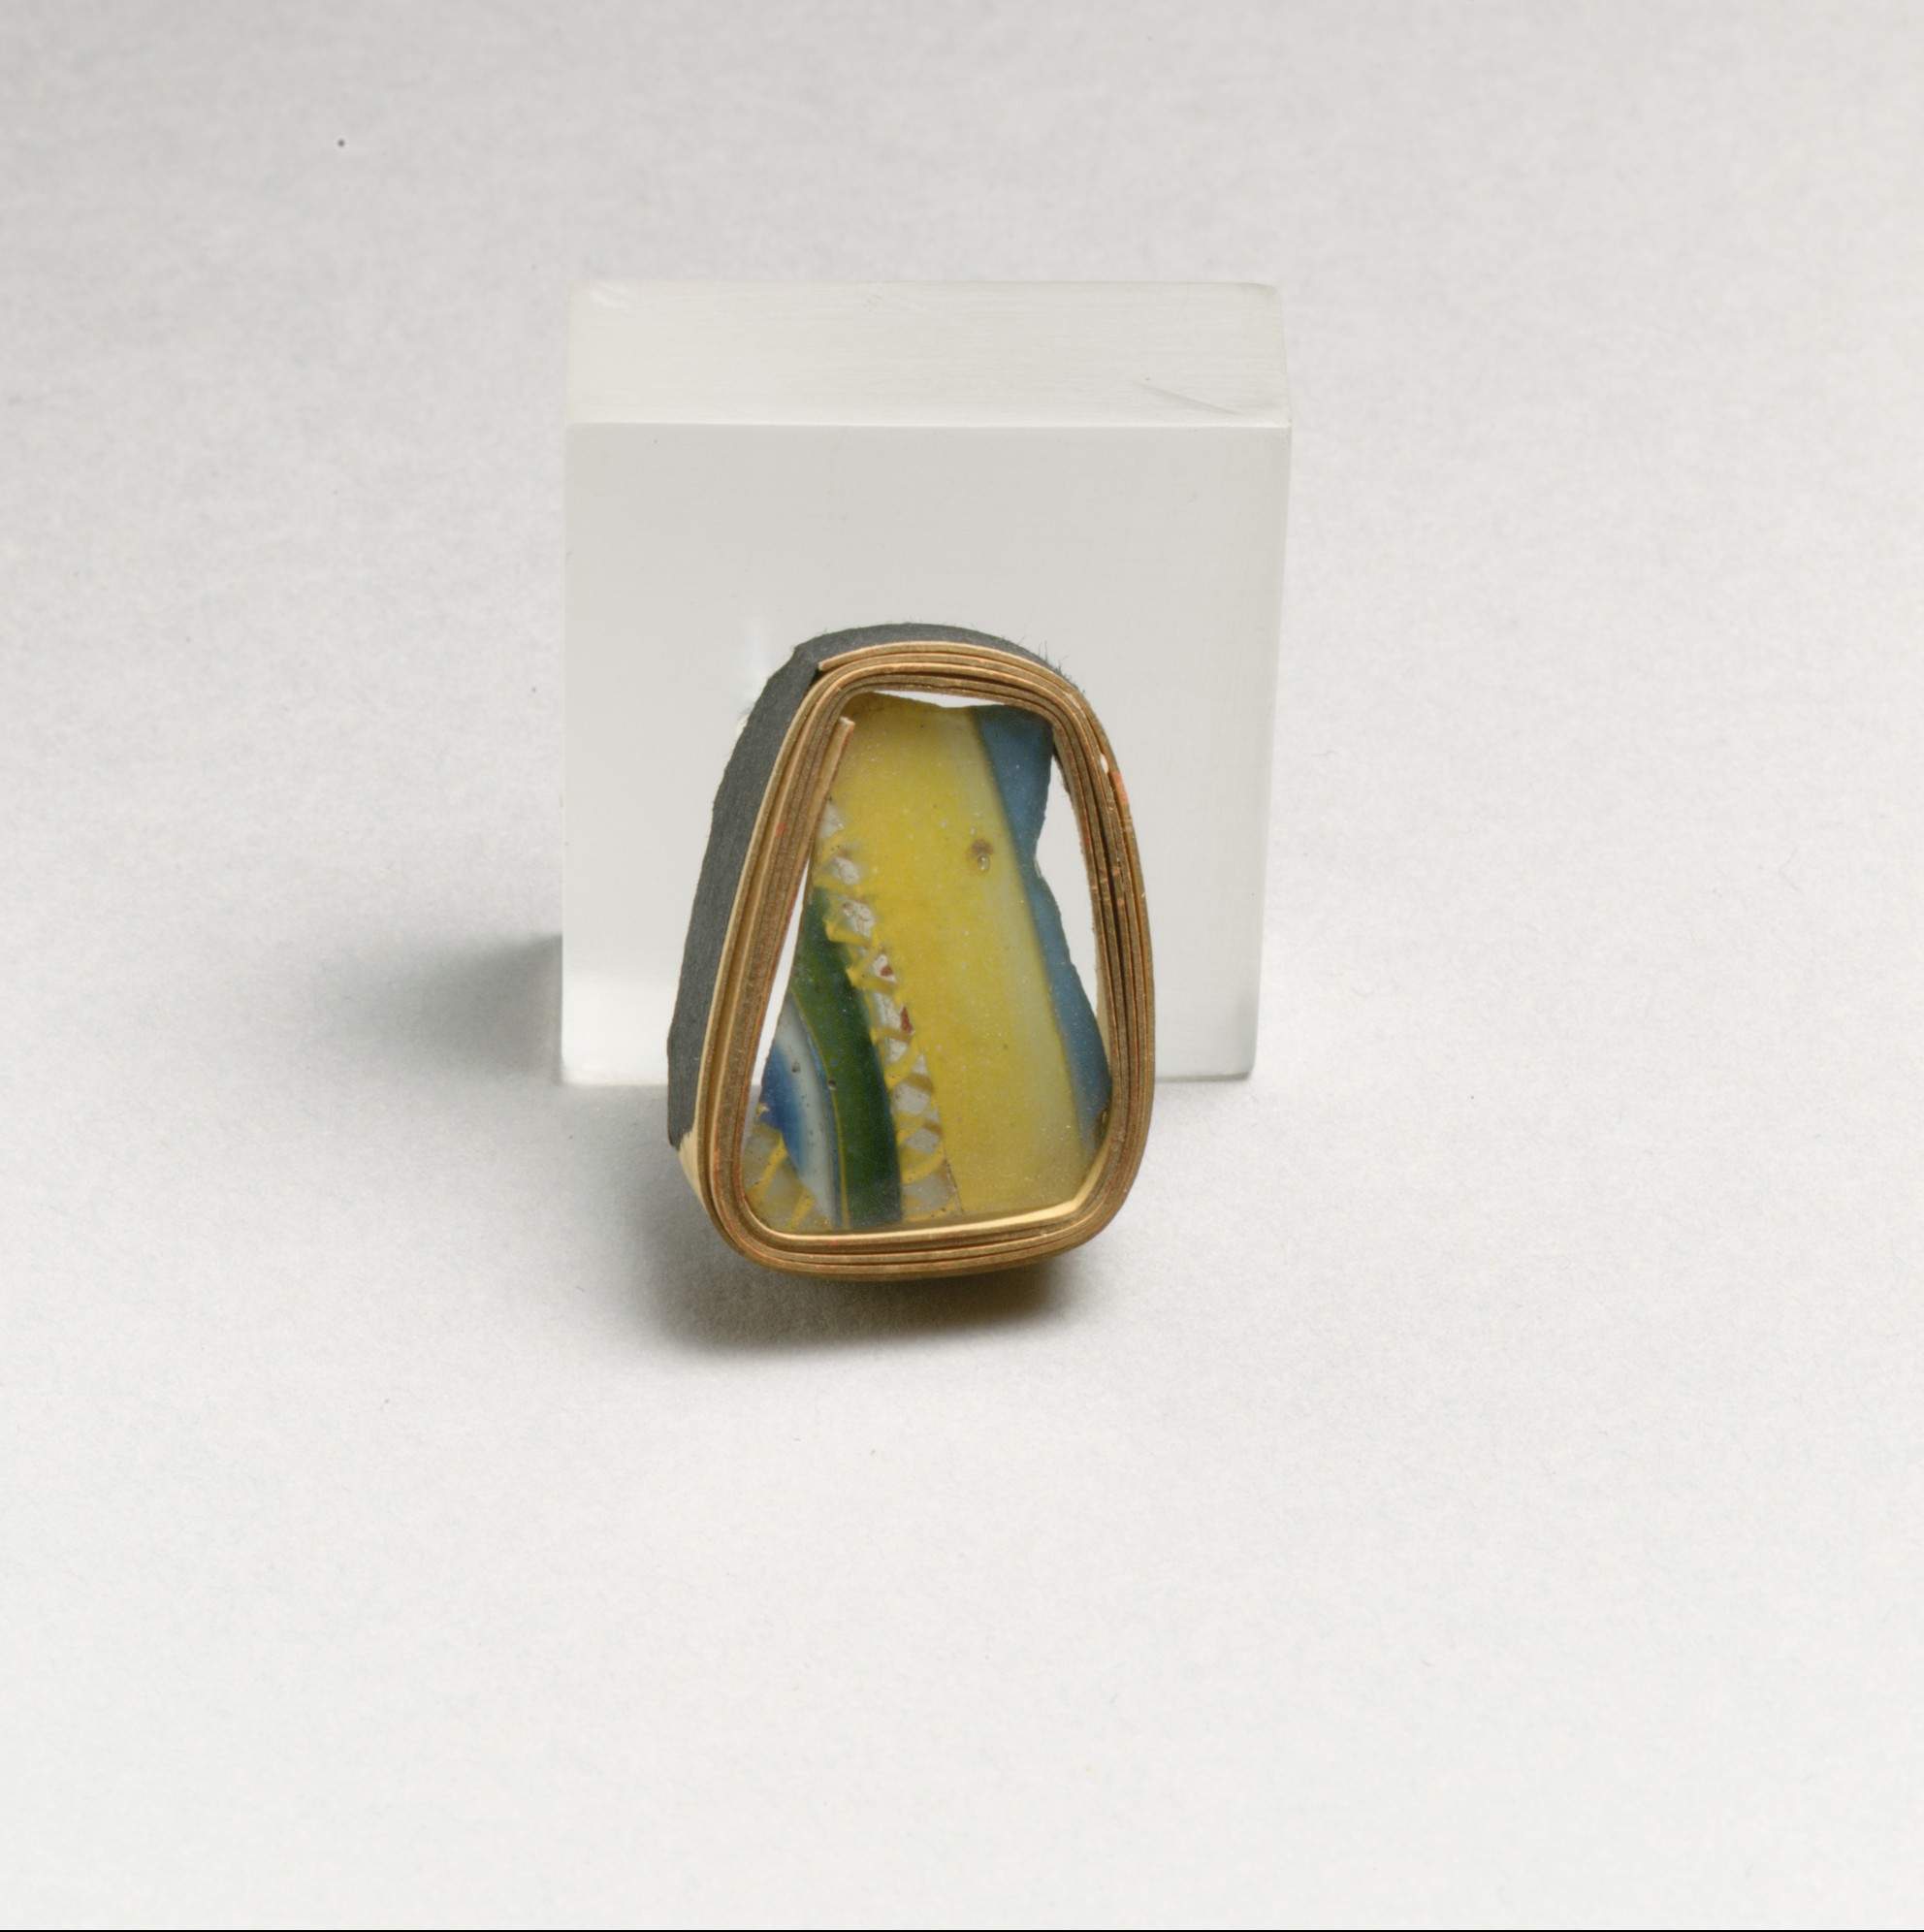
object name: fragment, striped mosaic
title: Glass striped mosaic fragment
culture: roman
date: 34 BCE-33 CE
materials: glass